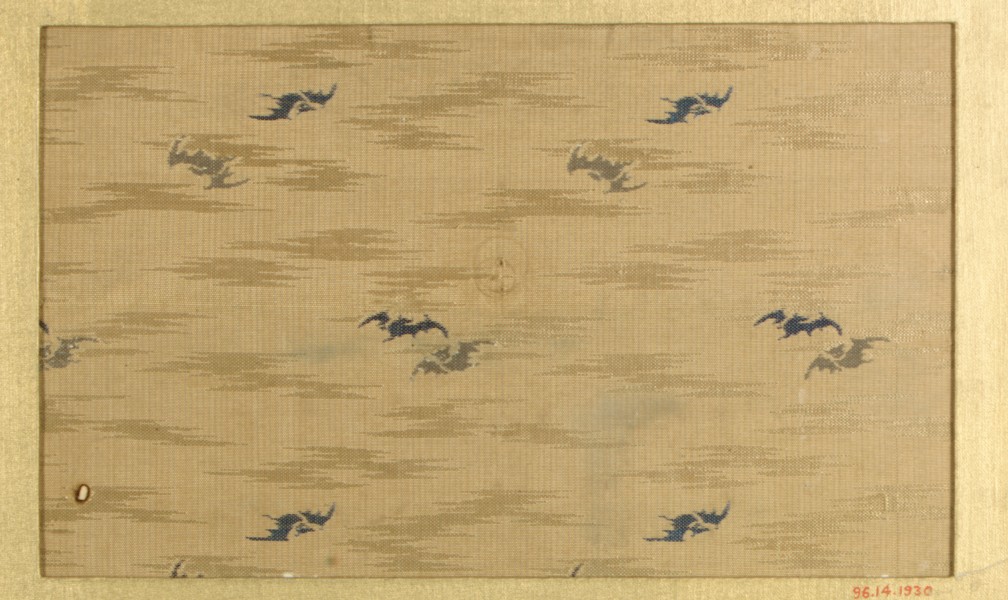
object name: piece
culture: japanese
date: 1701-1900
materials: silk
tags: bats